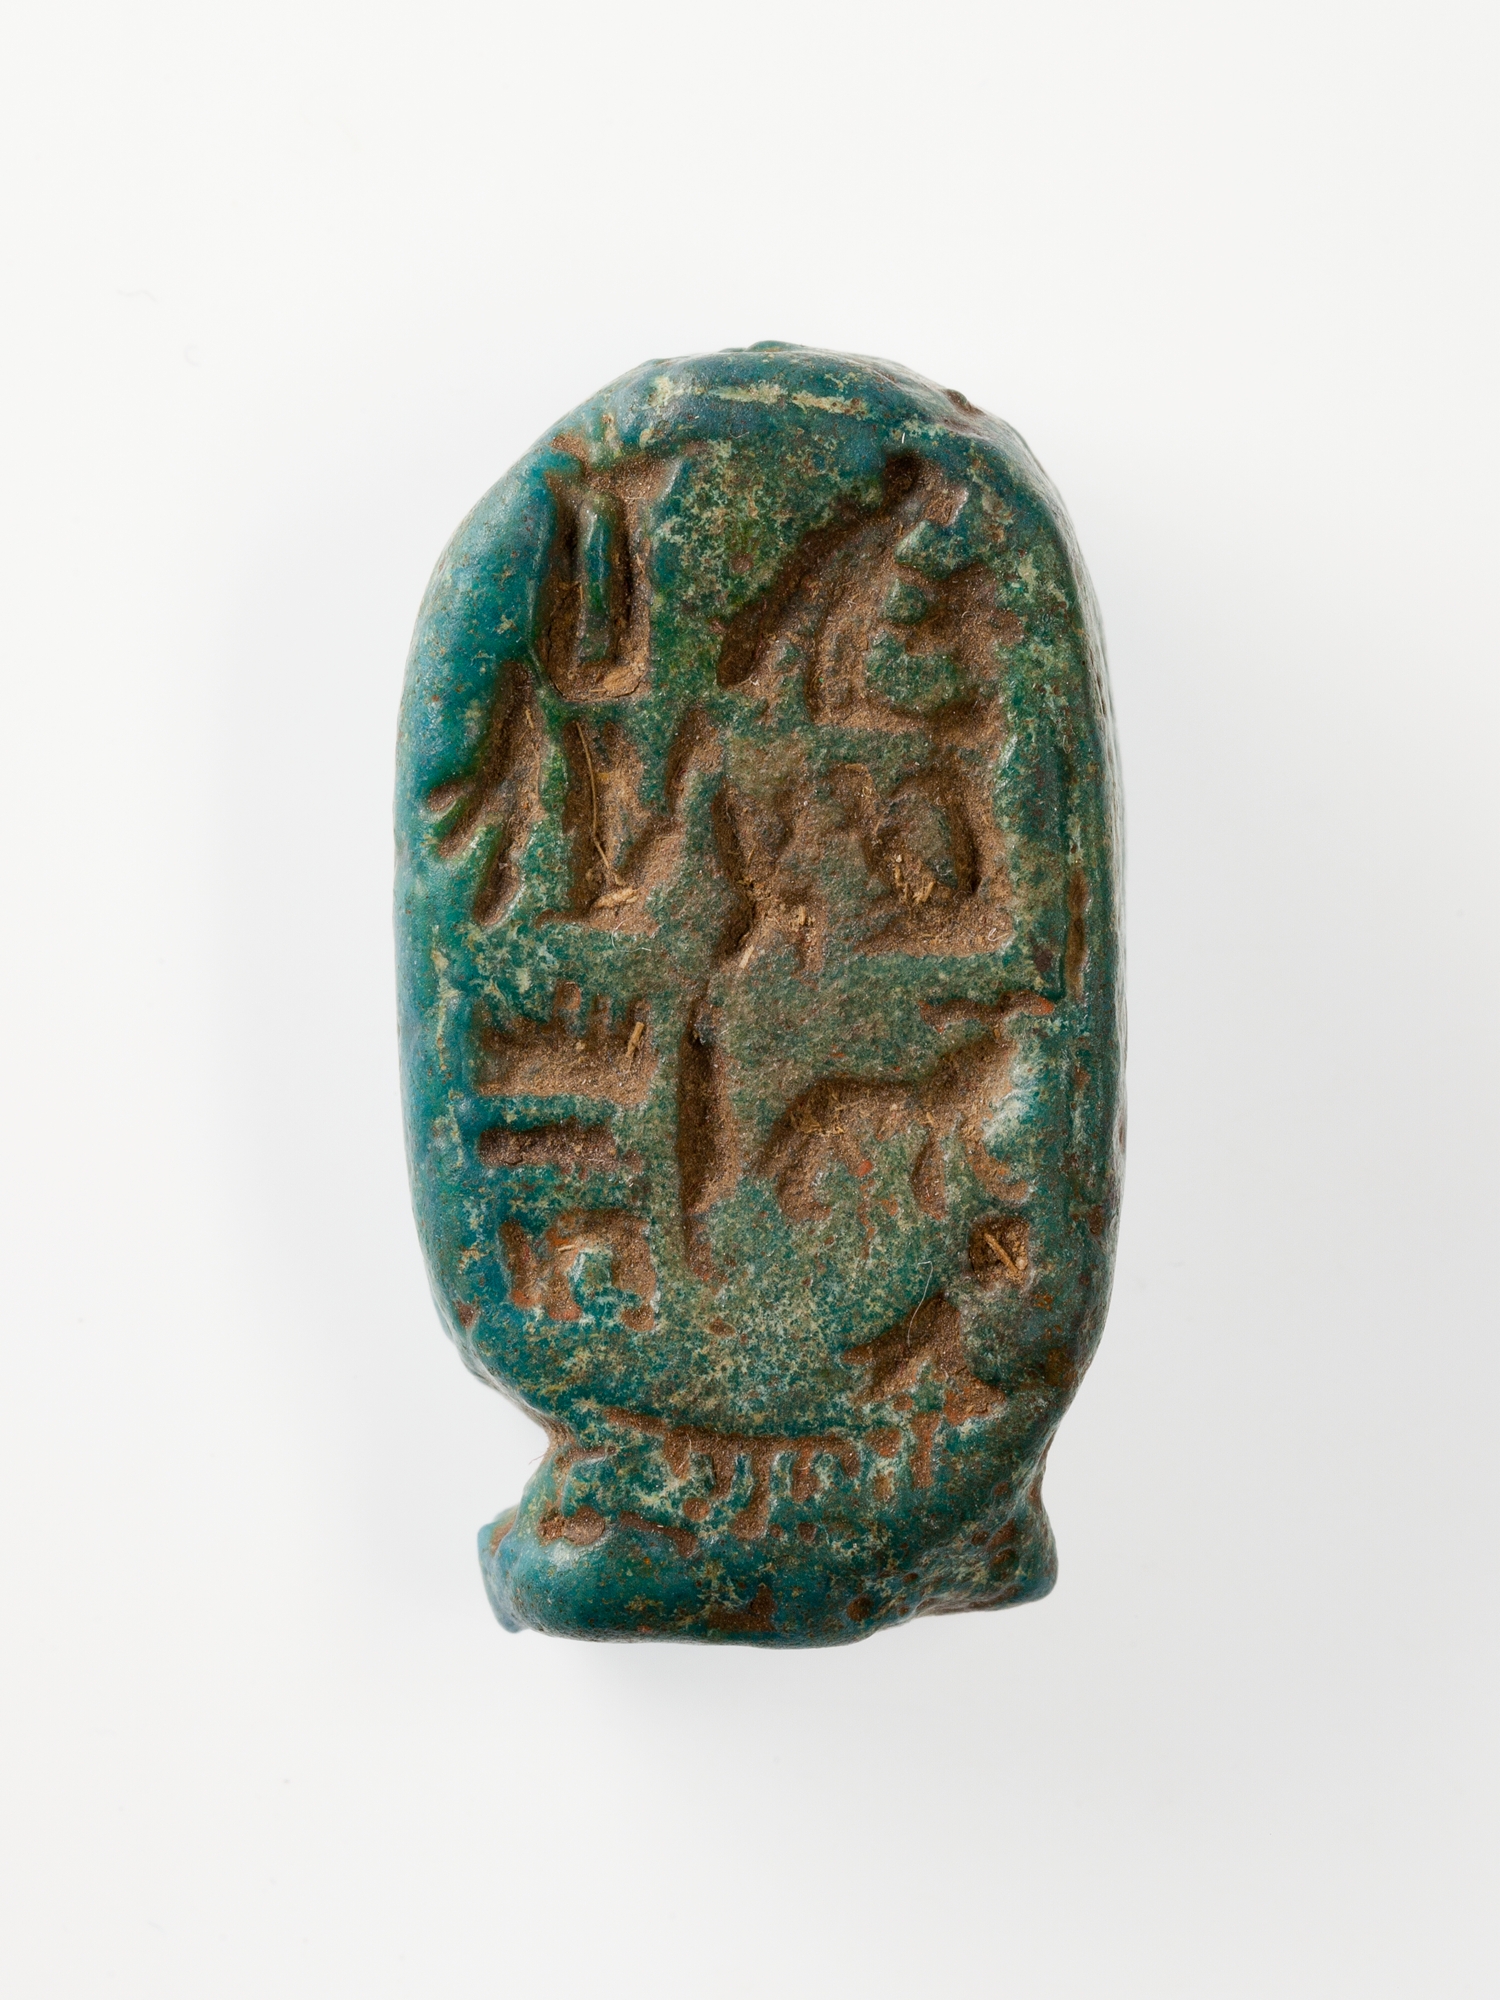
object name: seal plaque, merneptah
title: Plaque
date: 1295-1070 BCE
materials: faience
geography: egypt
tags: hieroglyphs